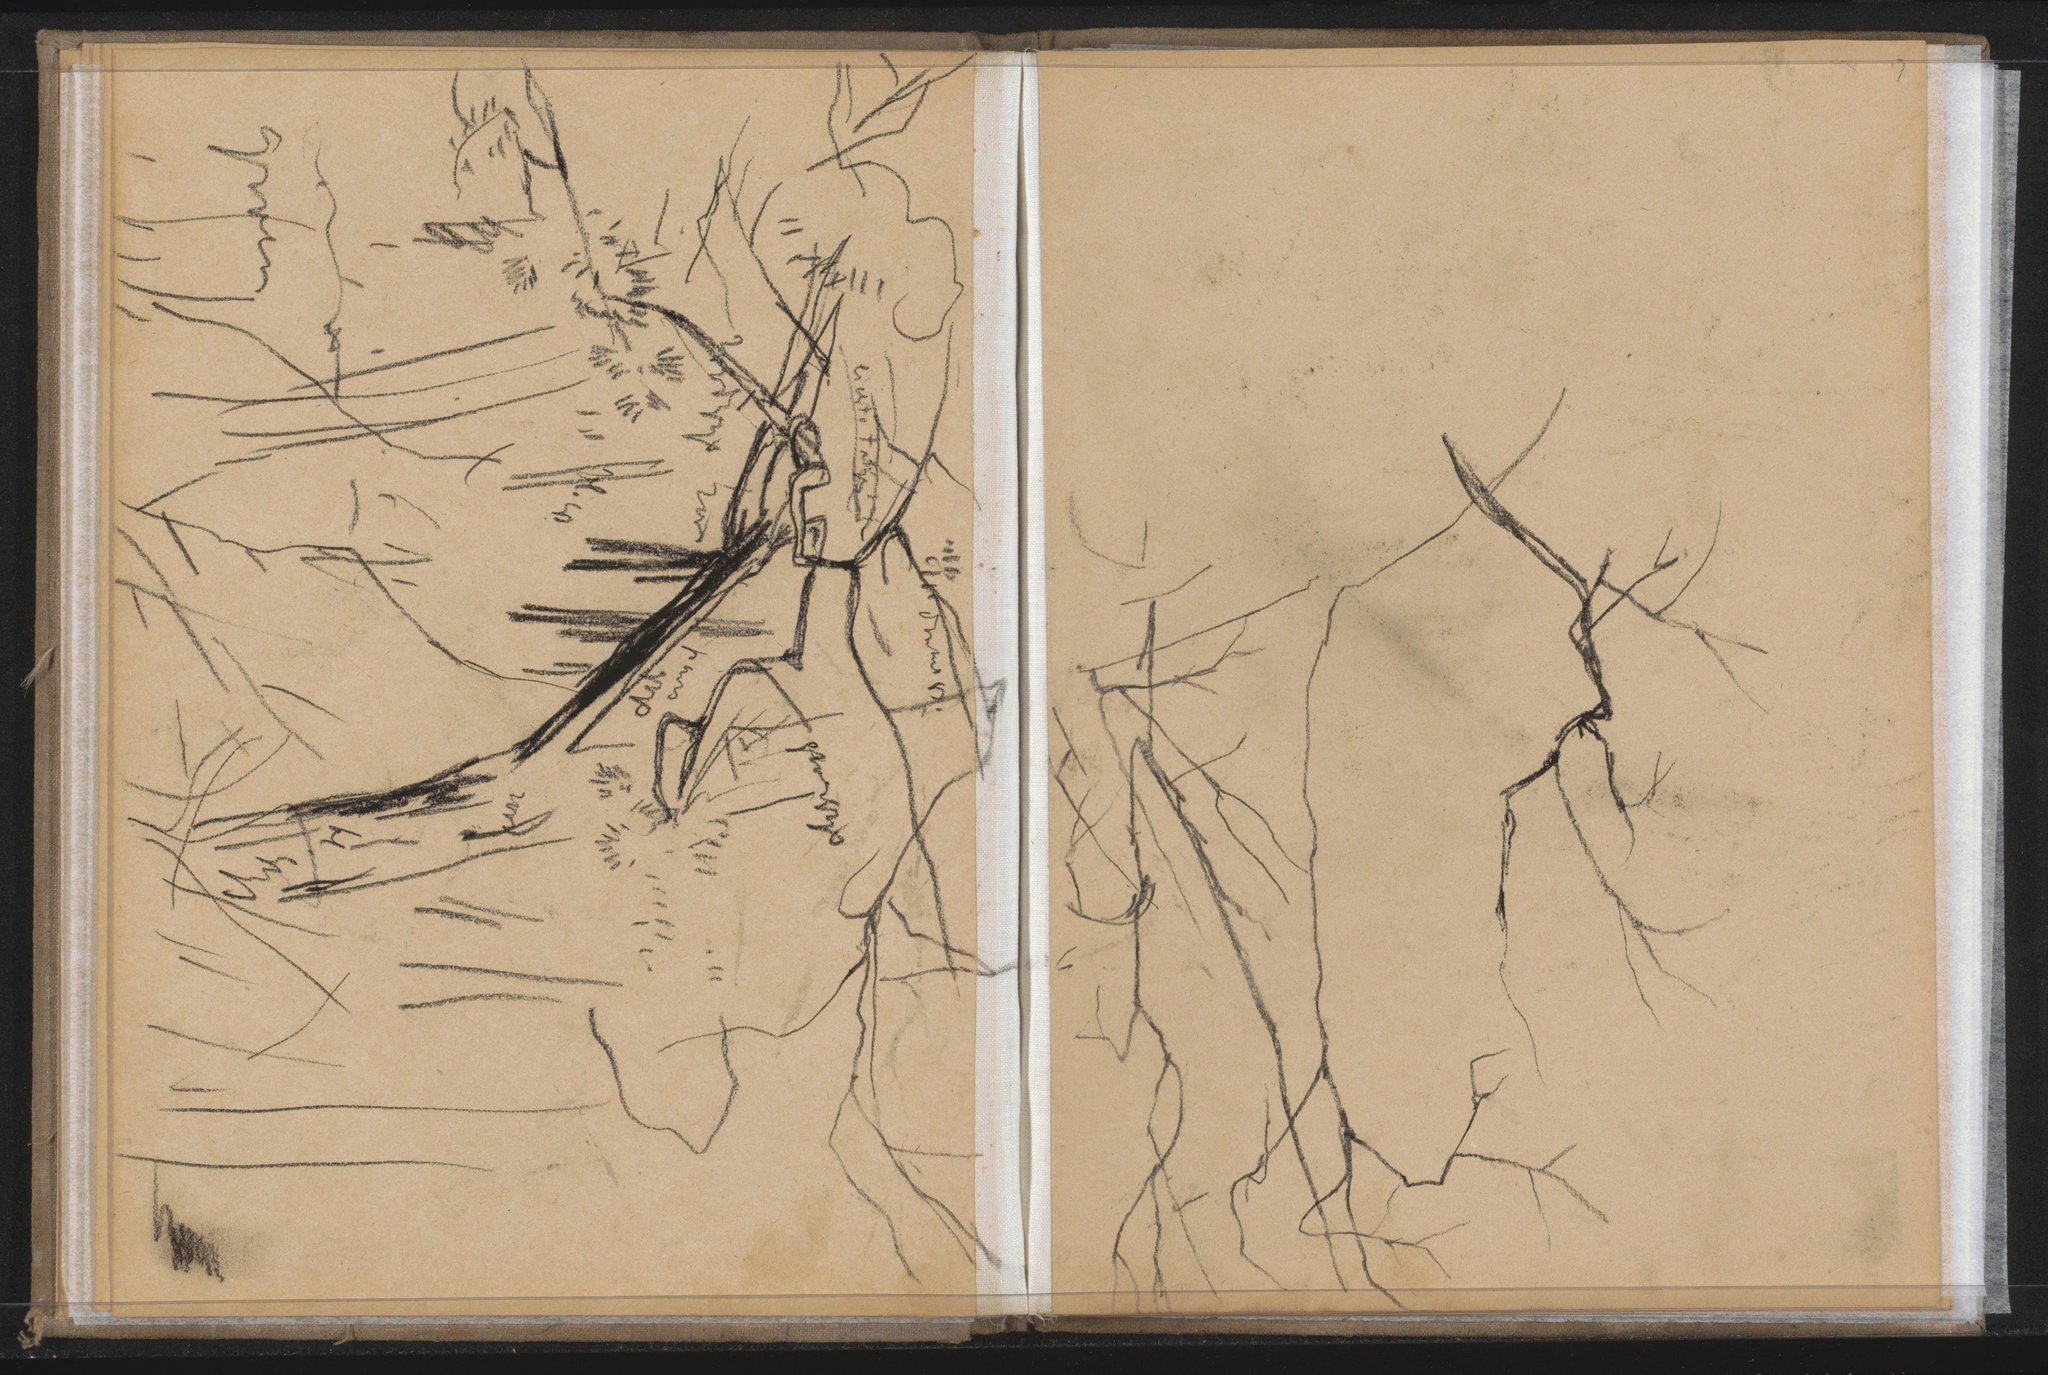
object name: sketchbook leaf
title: Bomen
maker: willem witsen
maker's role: draughtsman, painter, print maker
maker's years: 1860-1923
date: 1893-1897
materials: chalk, paper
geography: ede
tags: trees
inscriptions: kleurnotitie, handgeschreven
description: Pagina 16 en pagina 17 uit een schetsboek met 28 bladen.